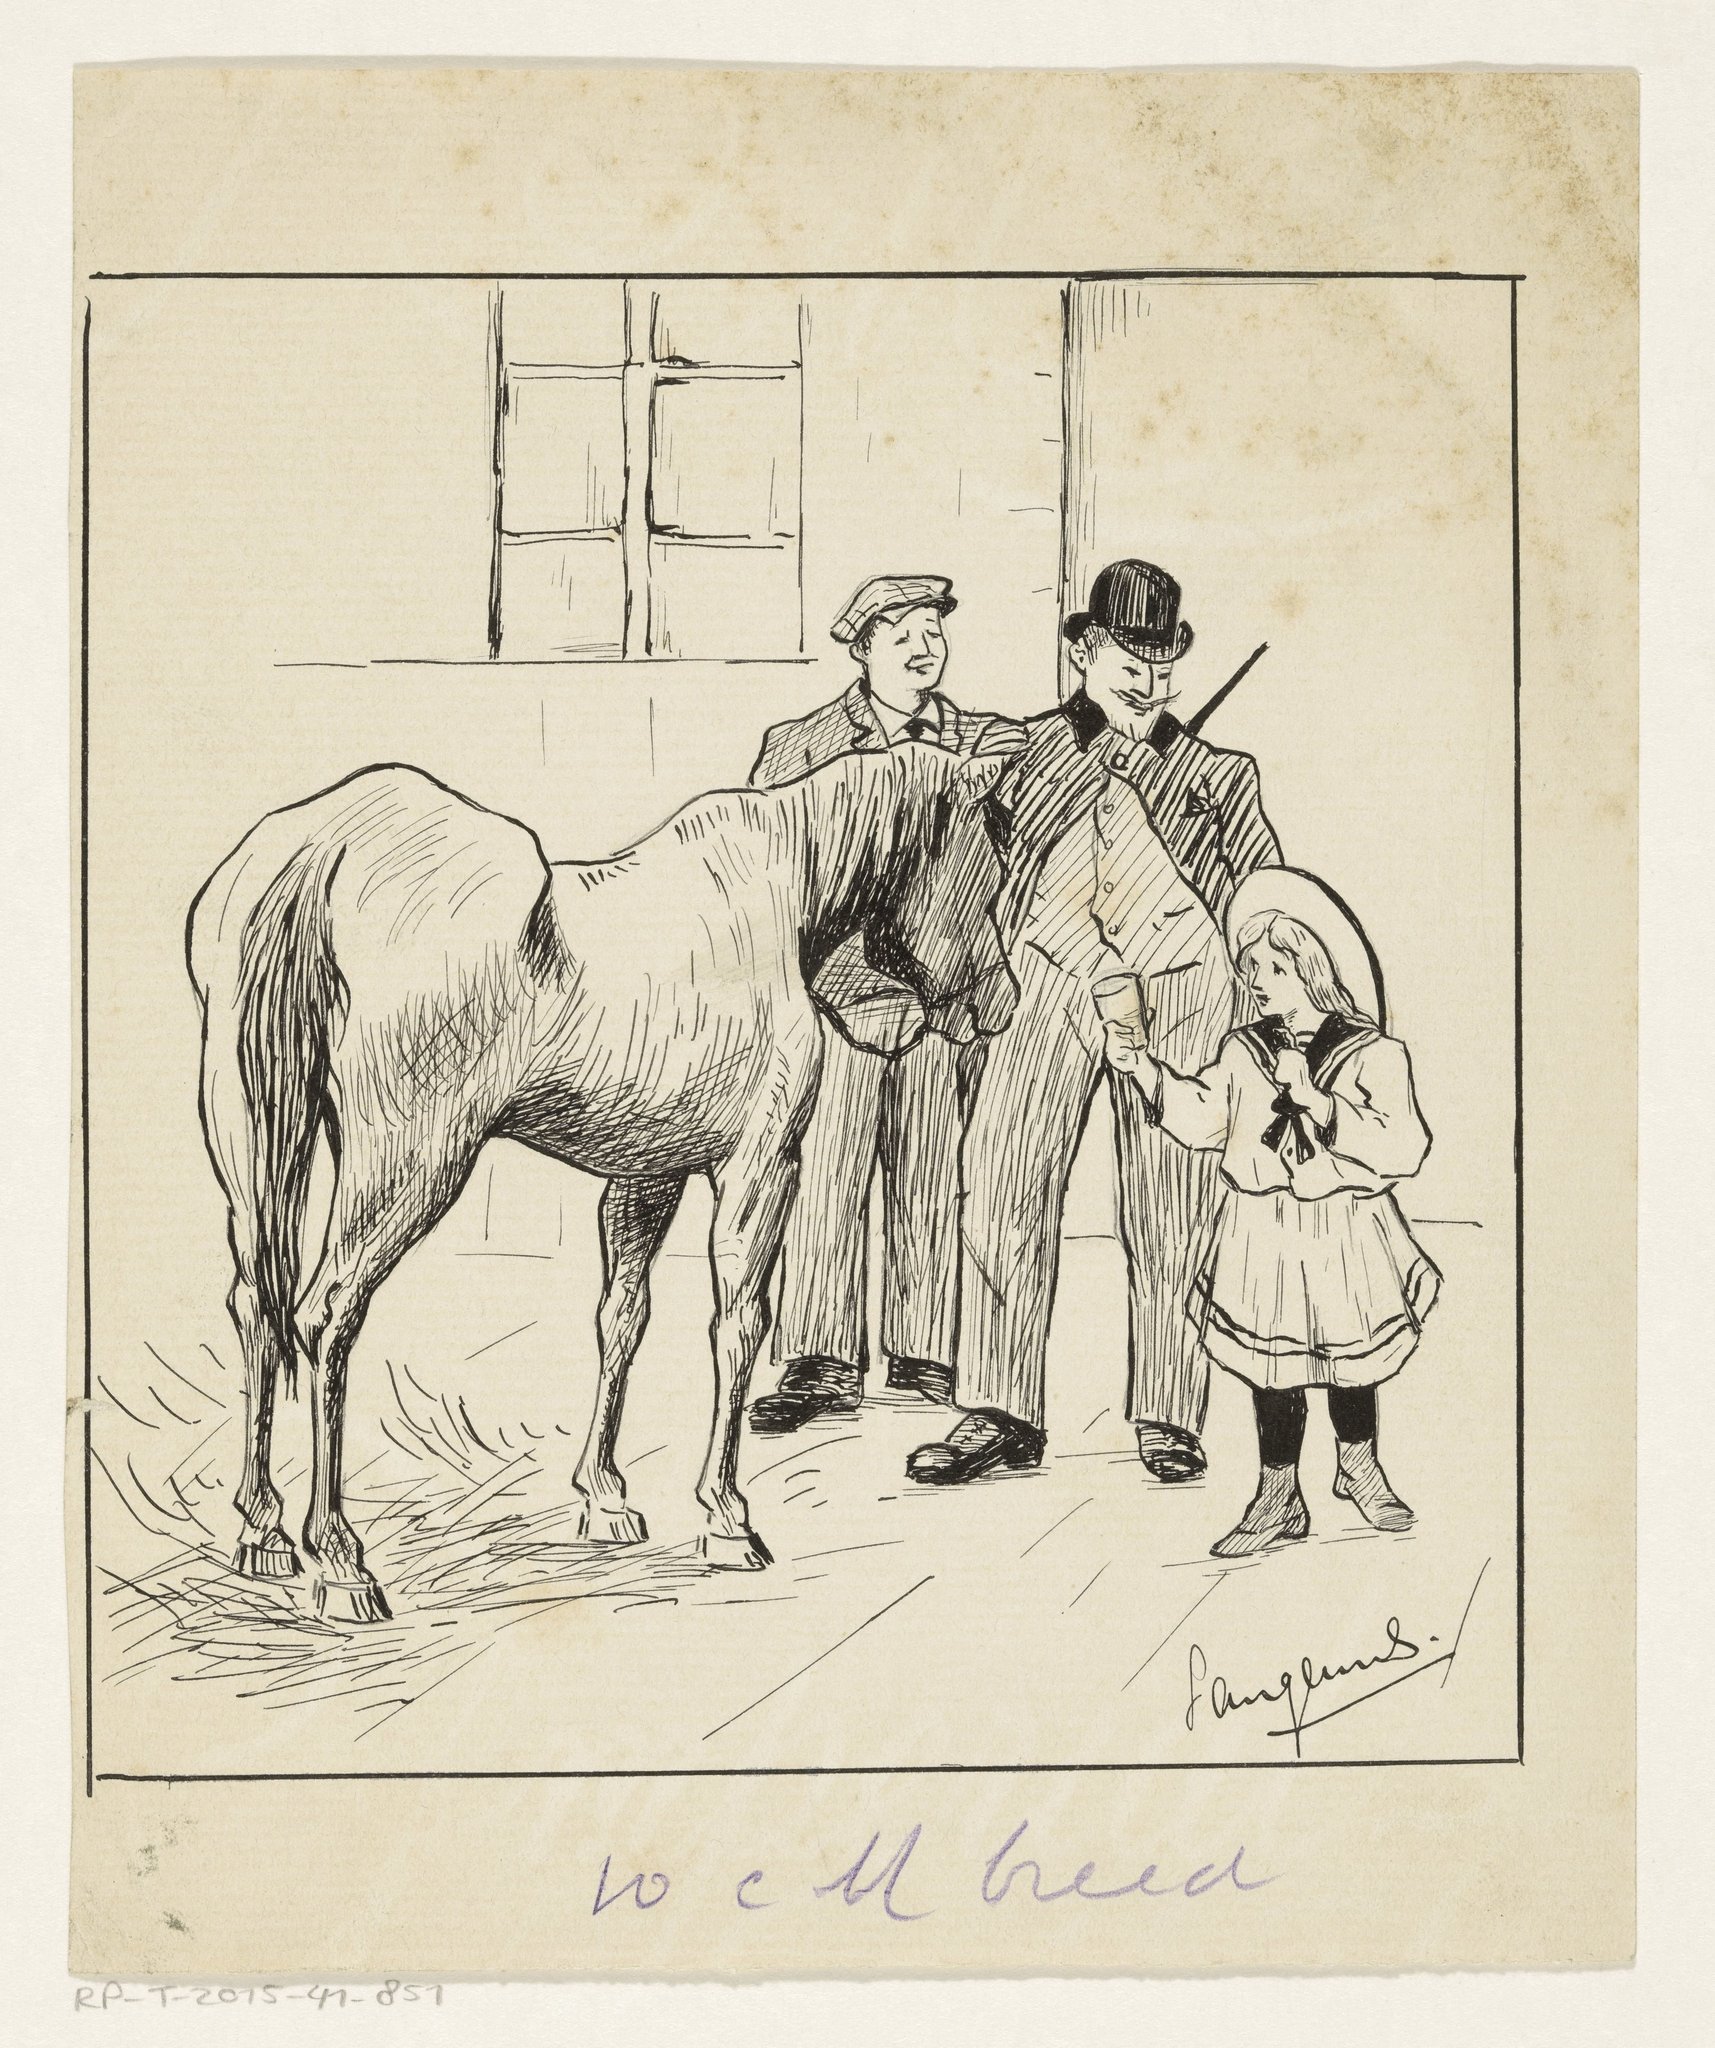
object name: drawing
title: Meisje biedt een paard water aan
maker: langenus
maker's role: draughtsman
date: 1900-1930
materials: ink, paper, pencil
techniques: pen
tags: girl (child between toddler and youth), glass, rummer, horse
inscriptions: signature: ‘Langenus.’, collector's mark: Lugt 2228, :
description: Twee mannen staan voor een paard. Naast hen staat een meisje in een matrozenpak. Ze houdt een glas water op voor het paard.